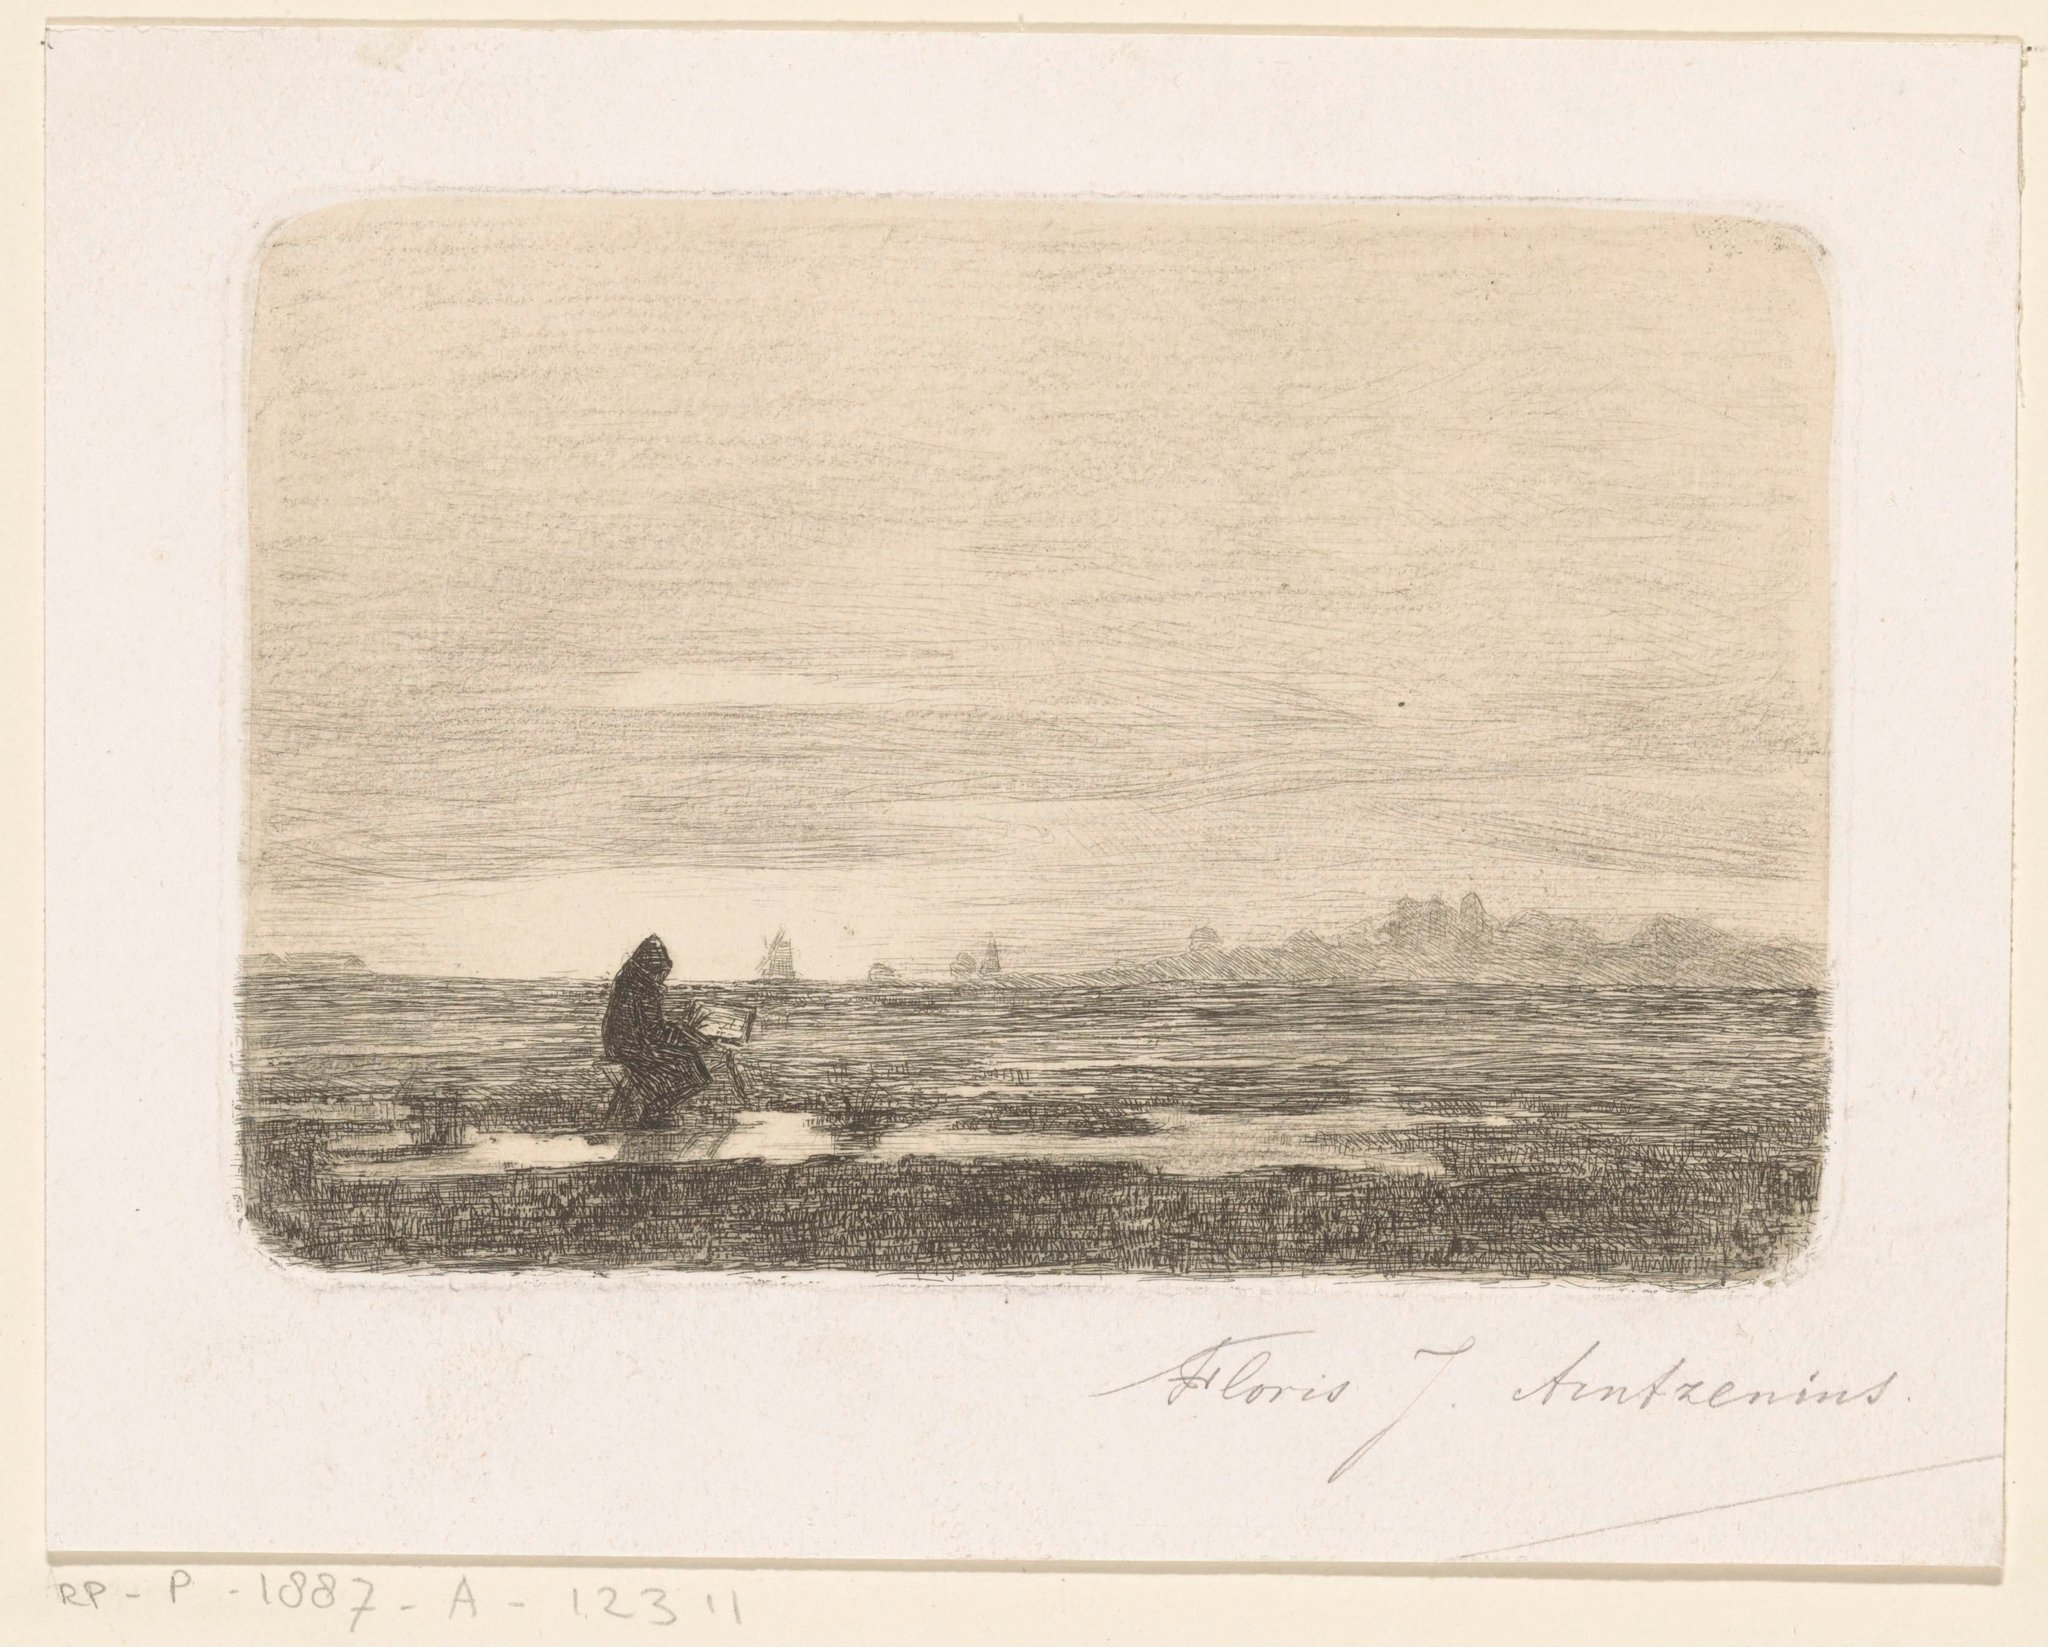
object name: print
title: De landschapsschilder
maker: floris arntzenius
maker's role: draughtsman, print maker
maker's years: 1864-1925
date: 1875-1887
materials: paper, ink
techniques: etching, intaglio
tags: painter at work, in his studio - cc - out of doors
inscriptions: signature: ‘Floris J. Arntzenius’, collector's mark: Lugt 2228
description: Polderlandschap met links een figuur achter een schildersezel, in de verte een molen en bomen.